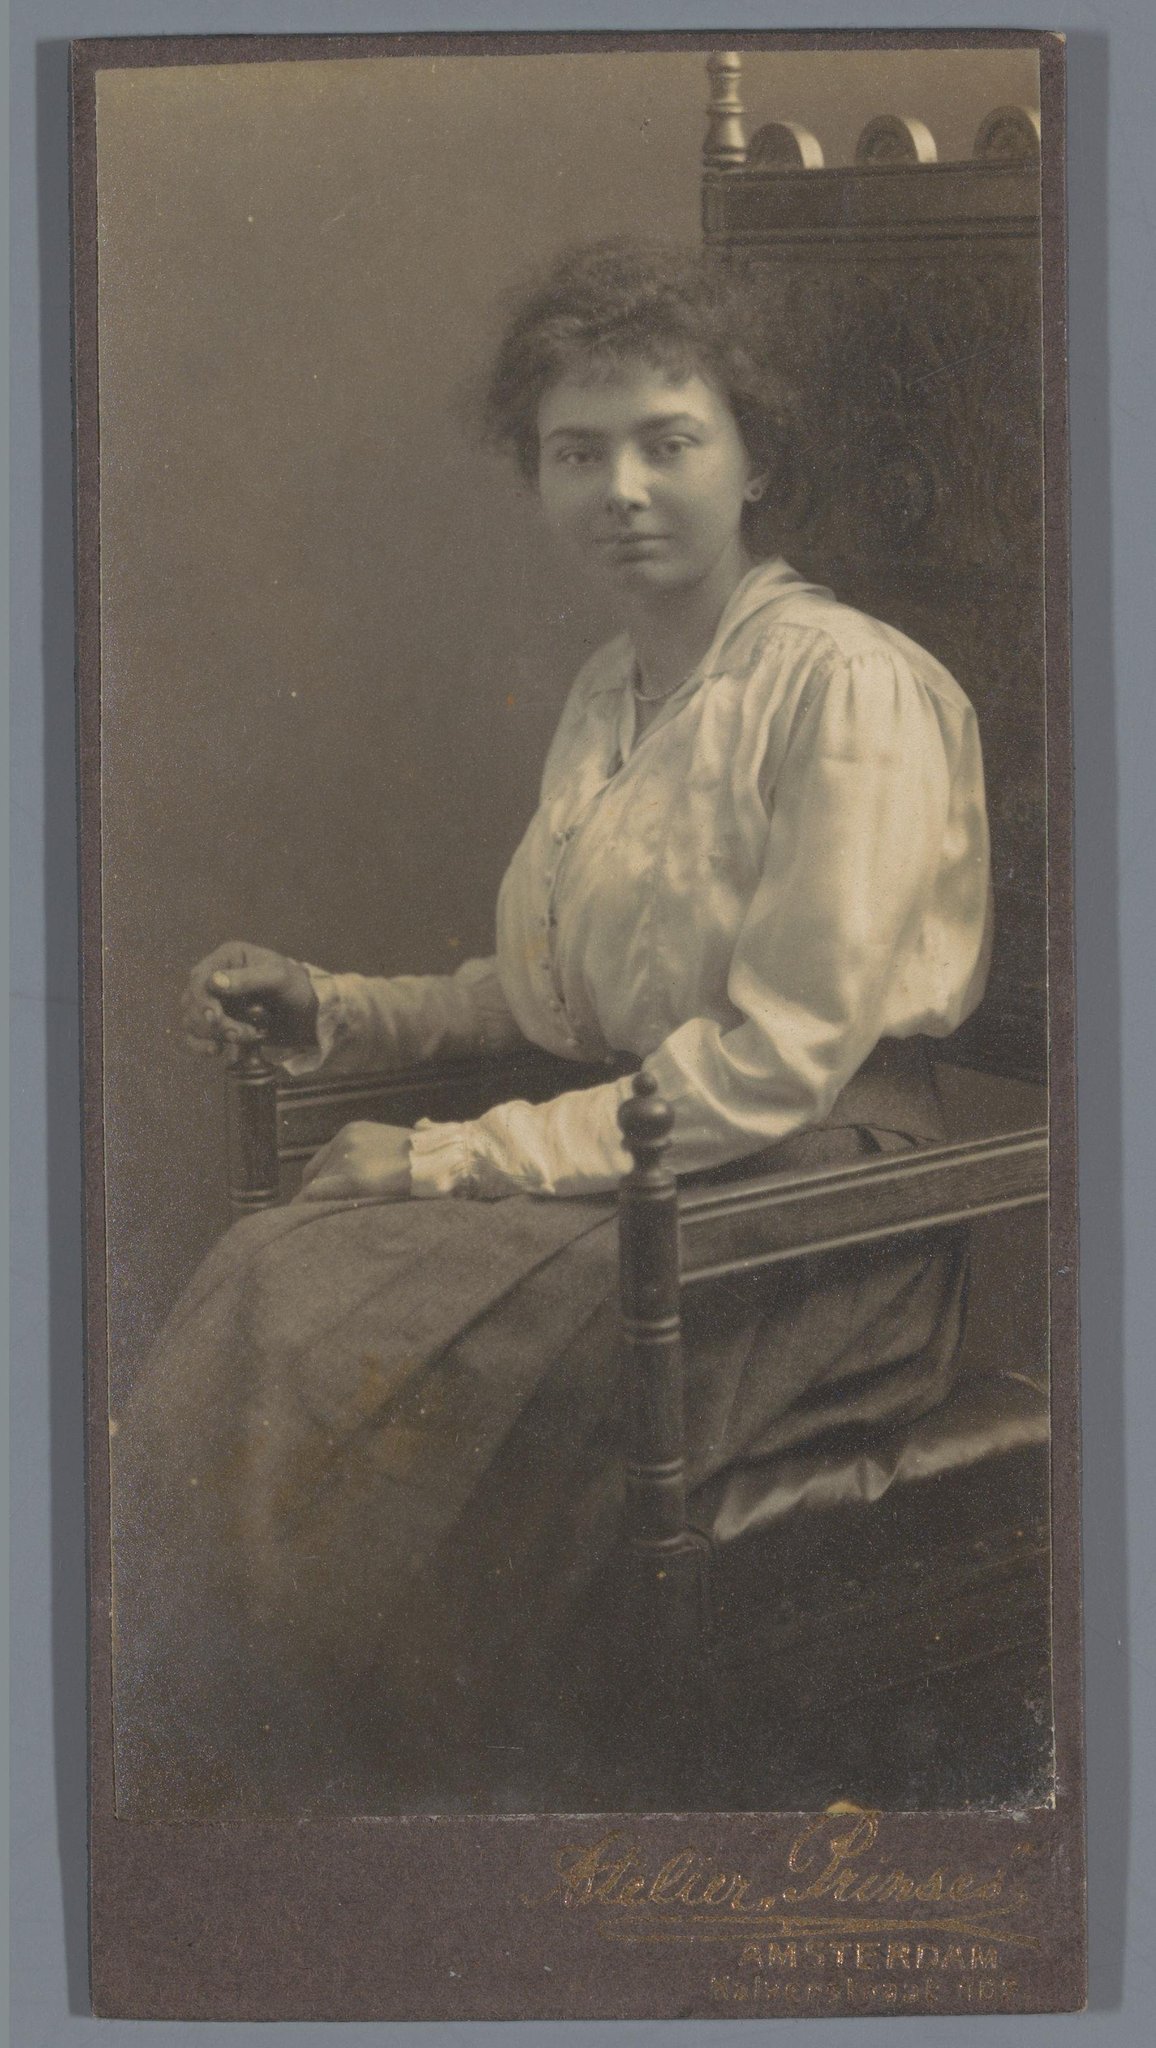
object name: carte de visite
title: Portret van een onbekende jonge vrouw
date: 1911-1914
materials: paper, cardboard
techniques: gelatin silver print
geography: amsterdam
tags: adolescent, young woman, maiden, anonymous historical person portrayed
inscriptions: number: ‘4830’, address: ‘AMSTERDAM/ Kalverstraat 103.’